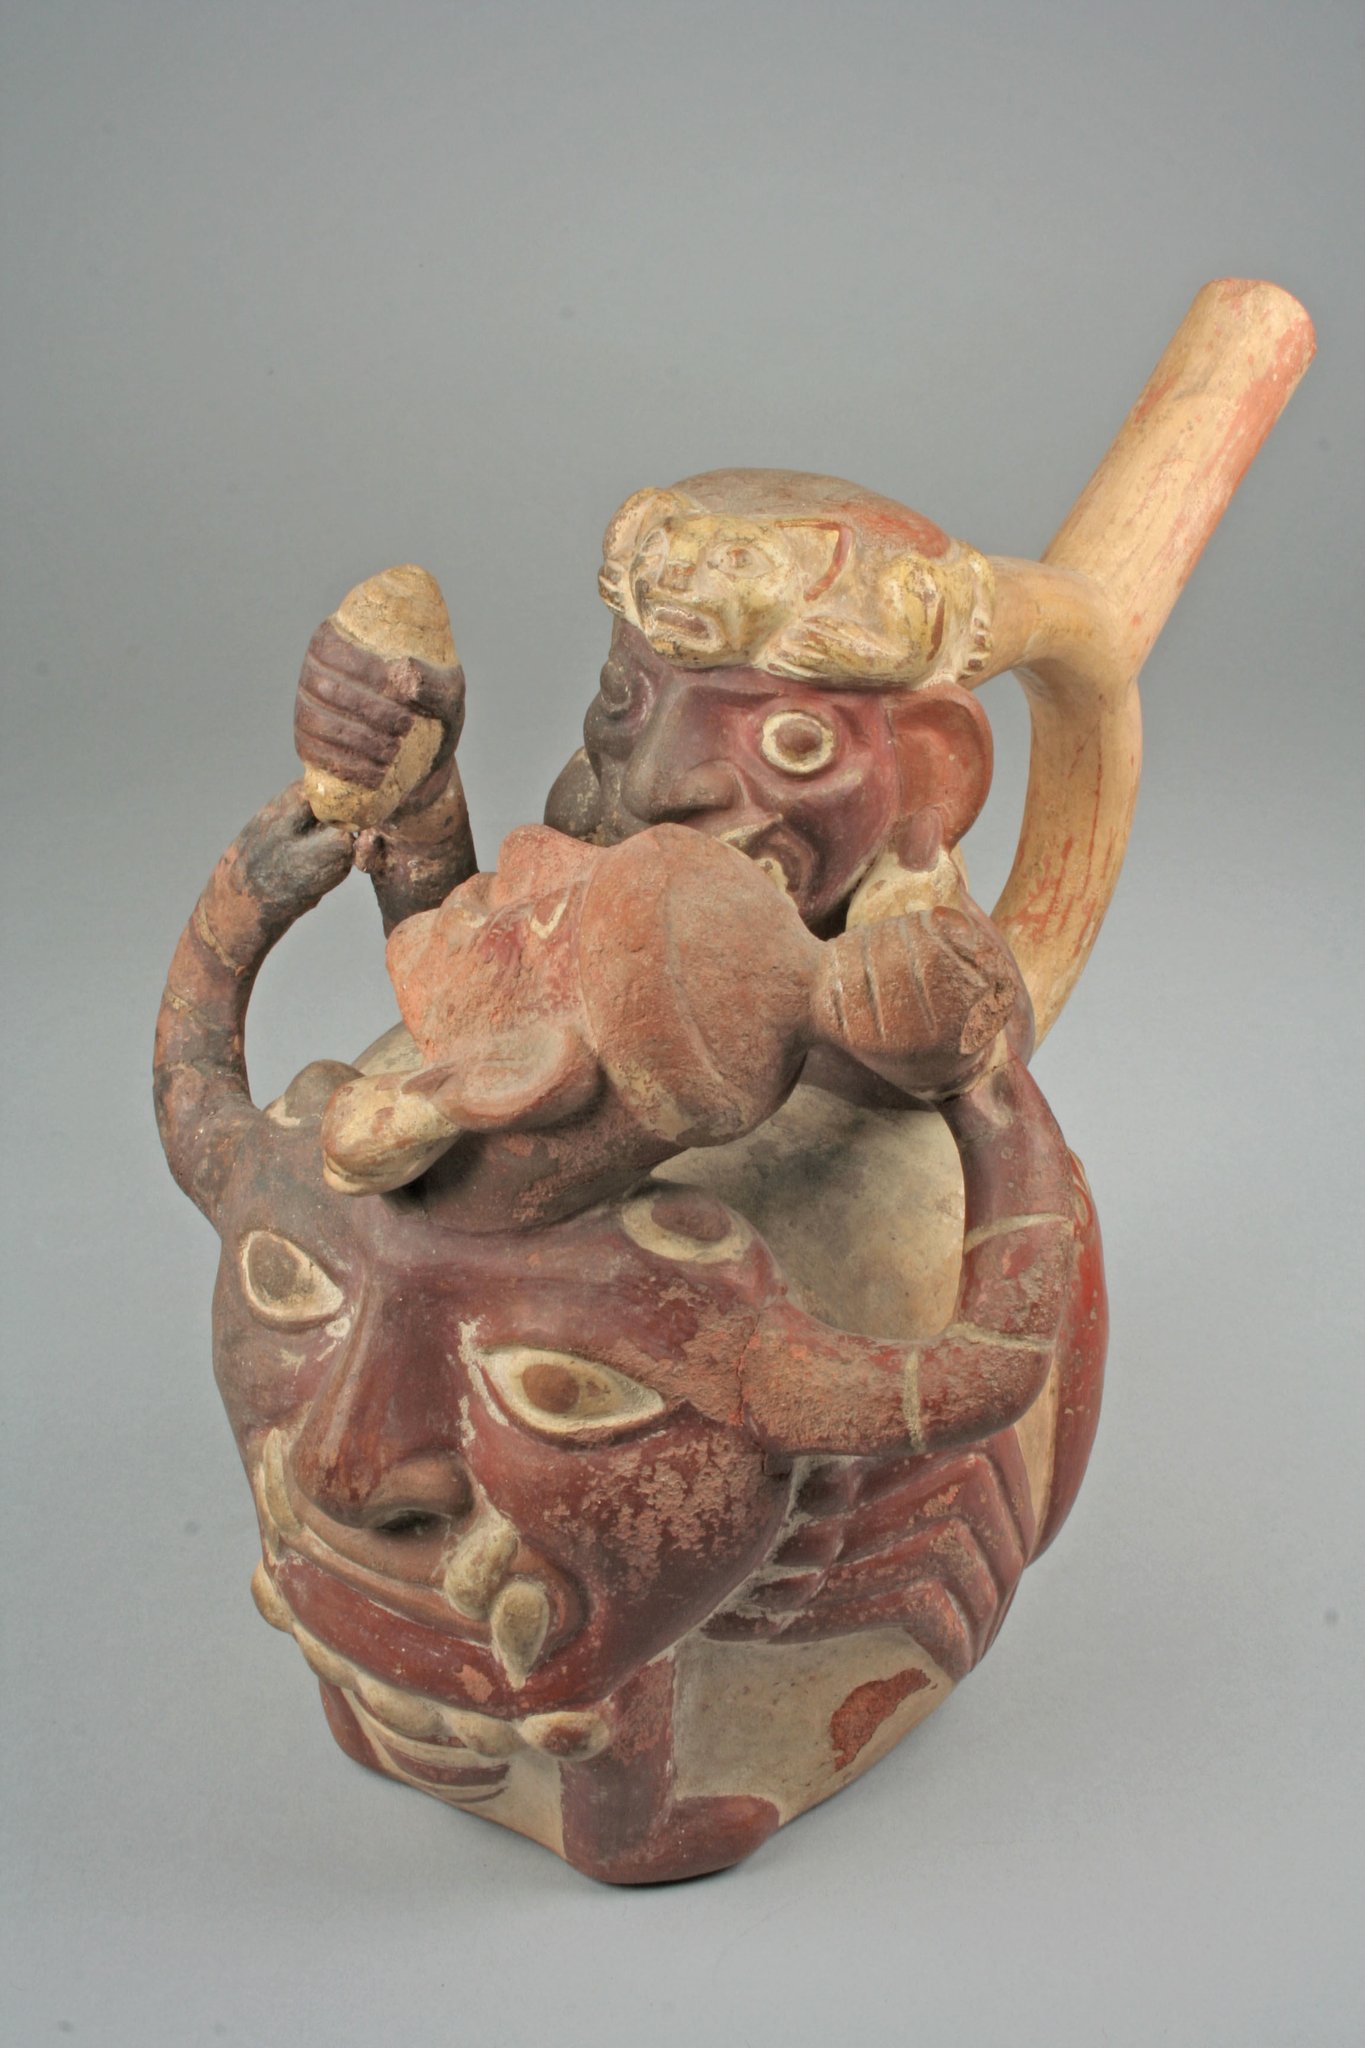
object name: bottle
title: Bottle, Crab Demon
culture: moche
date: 301-700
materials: ceramic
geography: peru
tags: demons